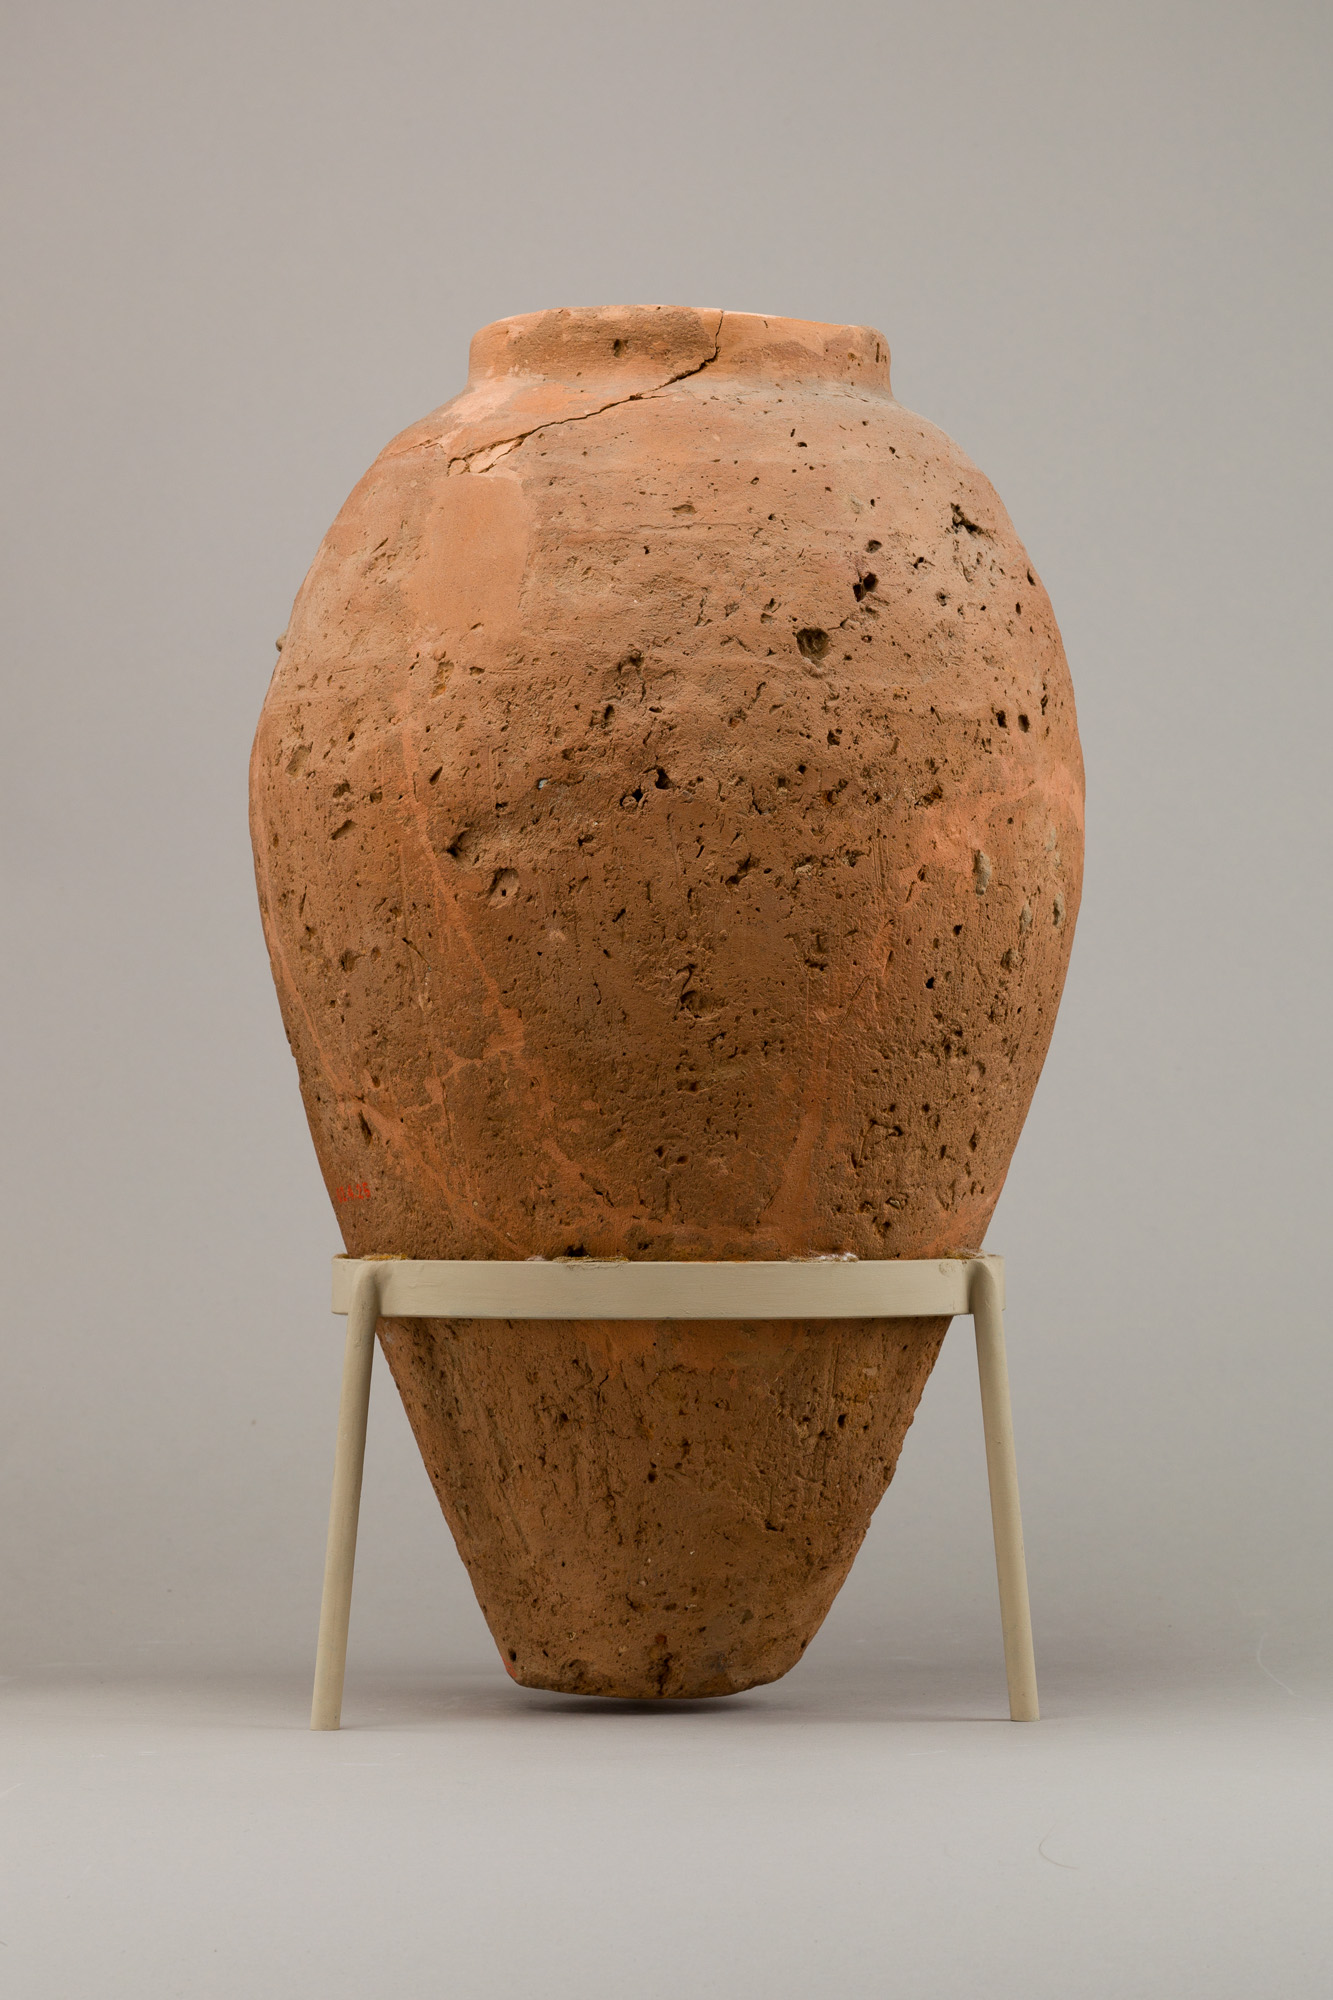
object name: jar, rough ware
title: Rough ware jar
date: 2960-2770 BCE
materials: pottery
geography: egypt